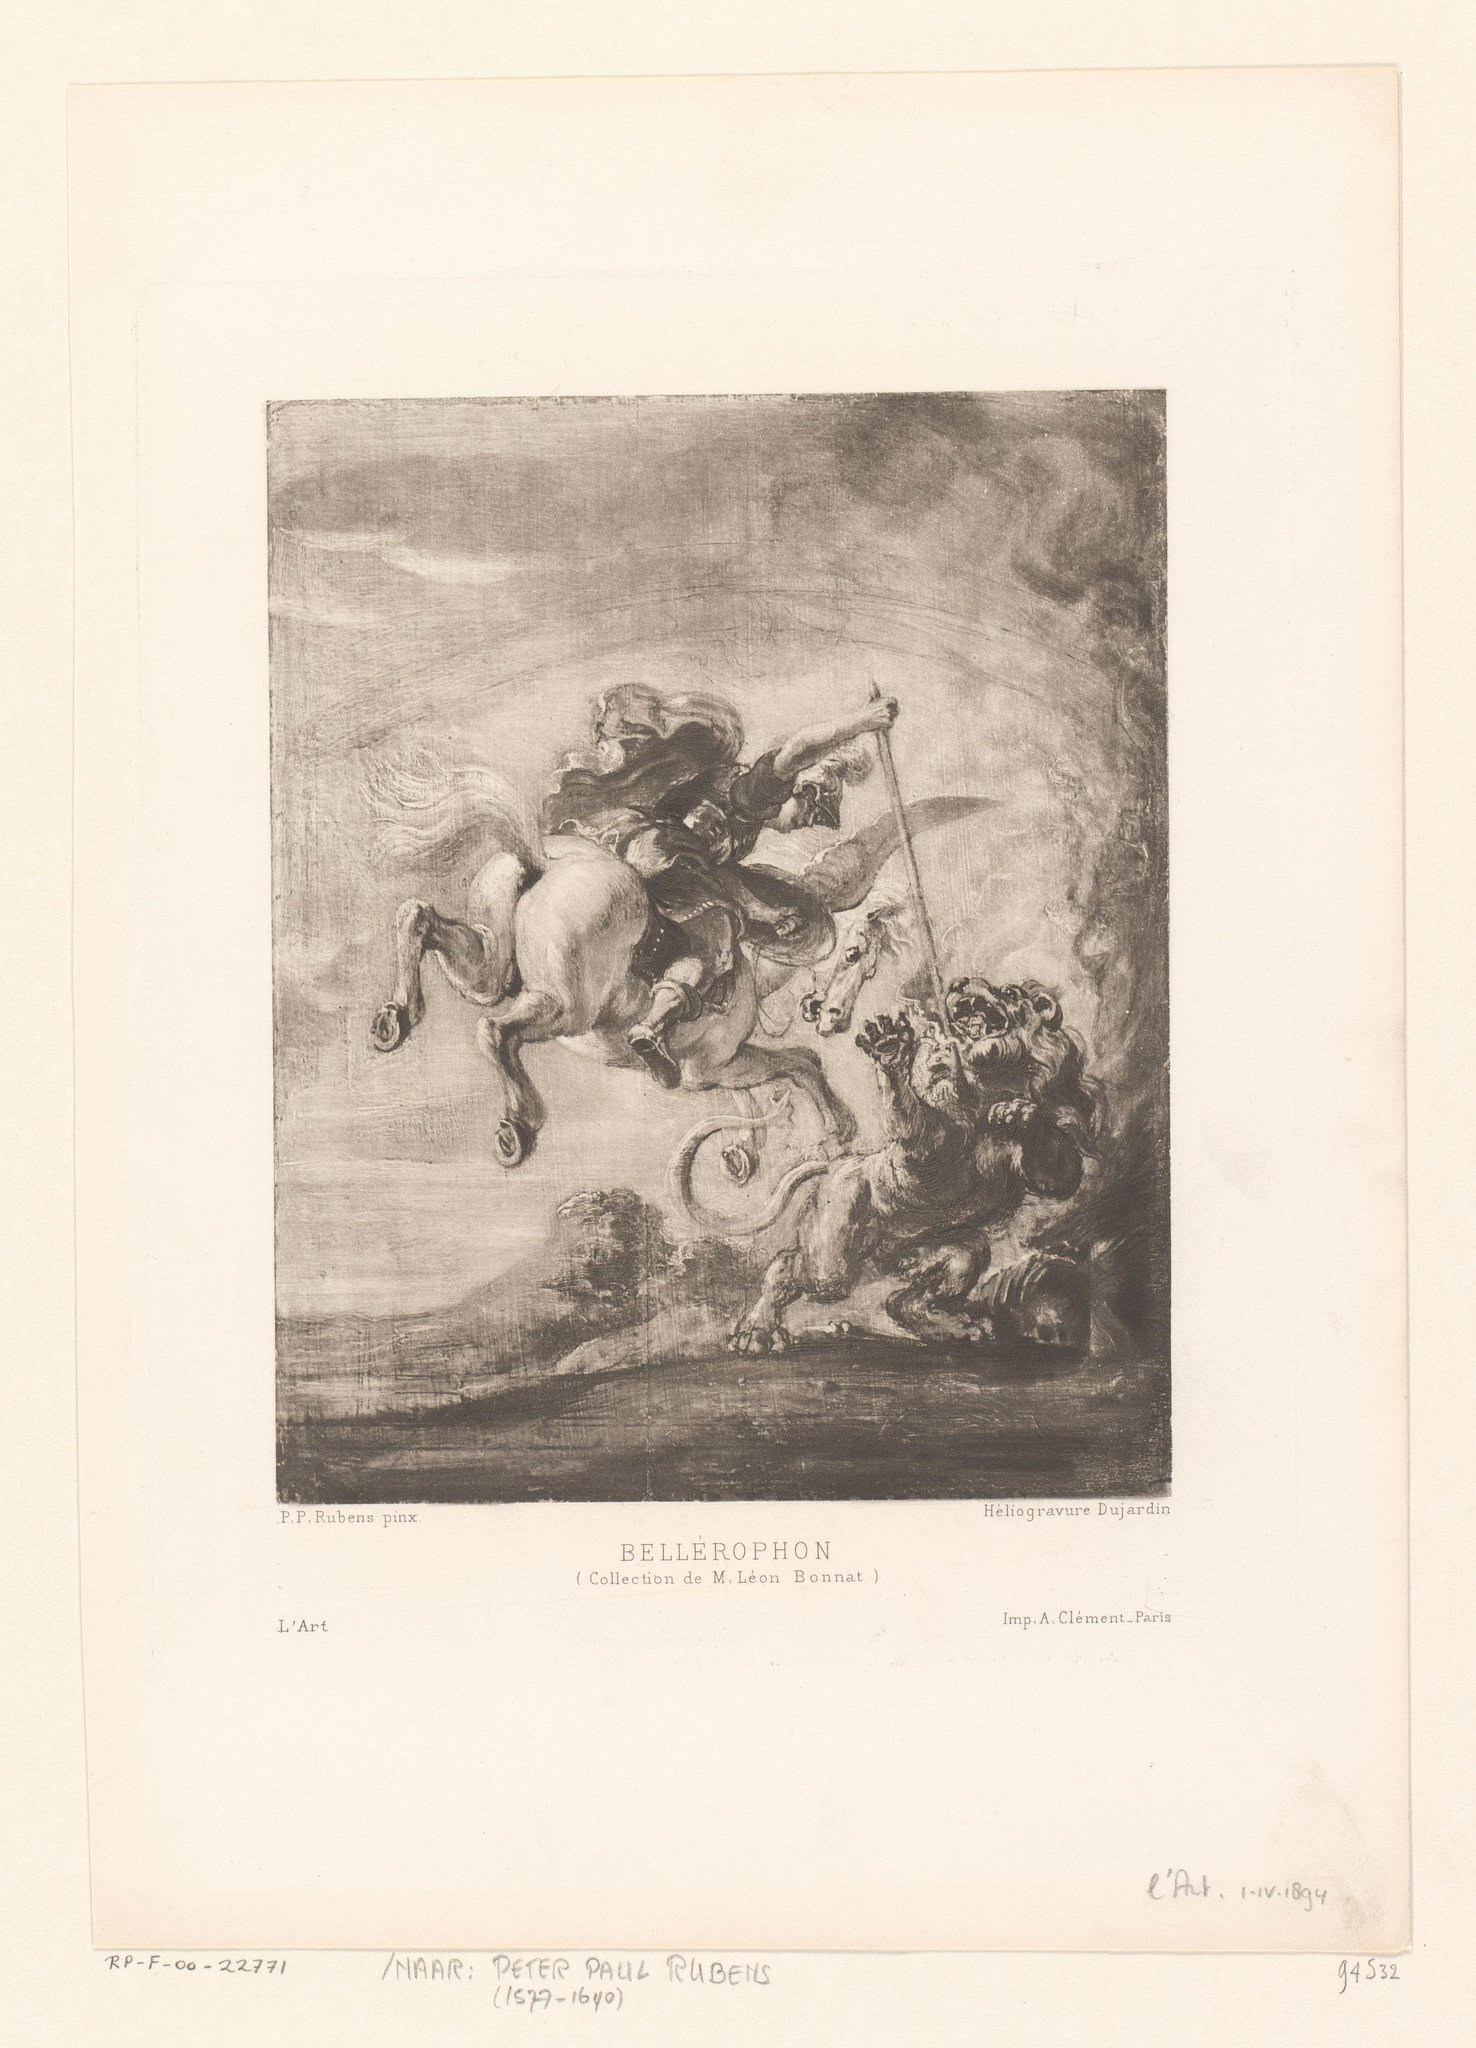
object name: reproduction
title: Fotoreproductie van het schilderij Bellerophon op Pegasus verslaat de Chimaera door Peter Paul Rubens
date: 1894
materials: paper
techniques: photoaquatint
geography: paris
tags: bellerophon, flying on pegasus' back, kills the chimera, a fire-breathing monster, with arrows or a spear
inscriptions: stamp: ‘ICON’, inscription: ‘l'Art 1-IV-1894’, collector's mark: Lugt 2228a, inscription: ‘(Collection de M. Léon Bonnat)/ L'Art’